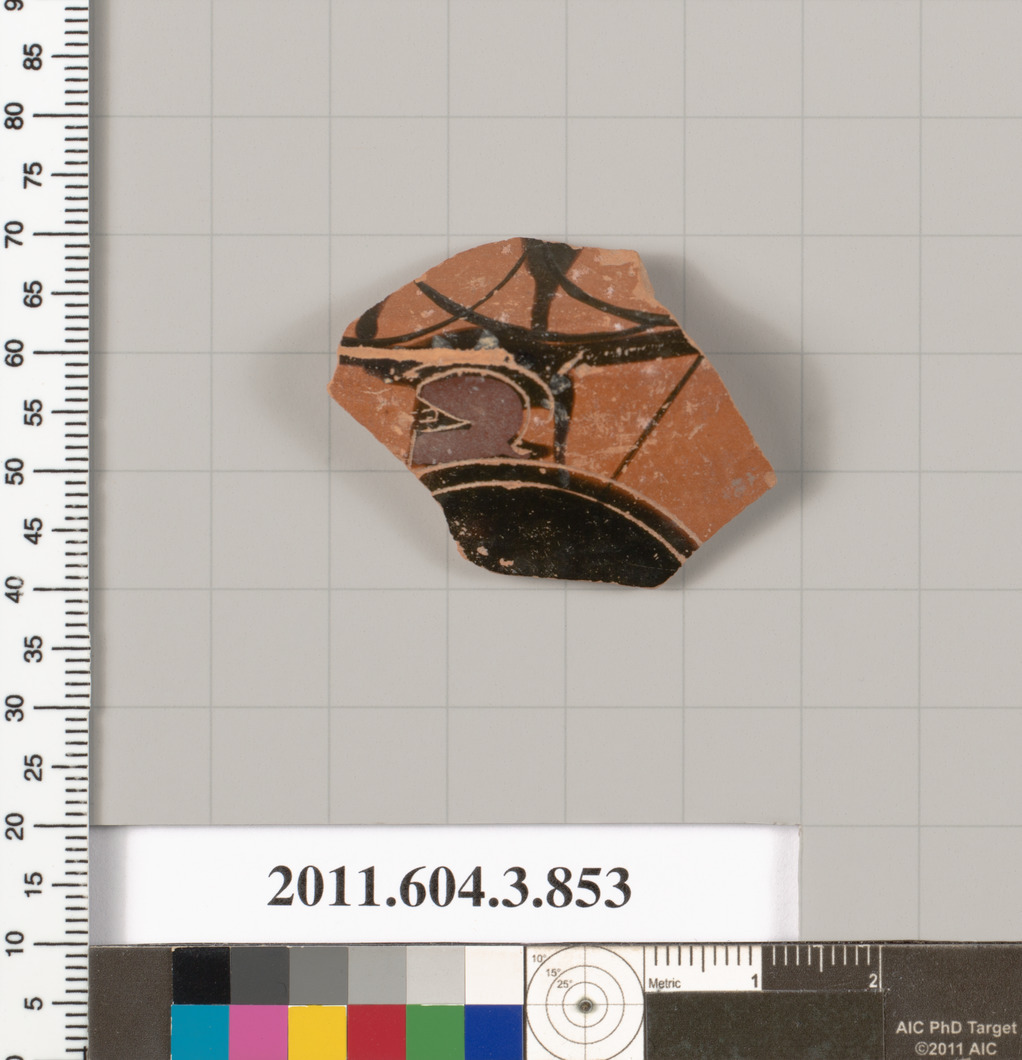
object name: lekythos fragment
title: Terracotta fragment of a lekythos (oil flask)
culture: greek, attic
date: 534-501 BCE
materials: terracotta